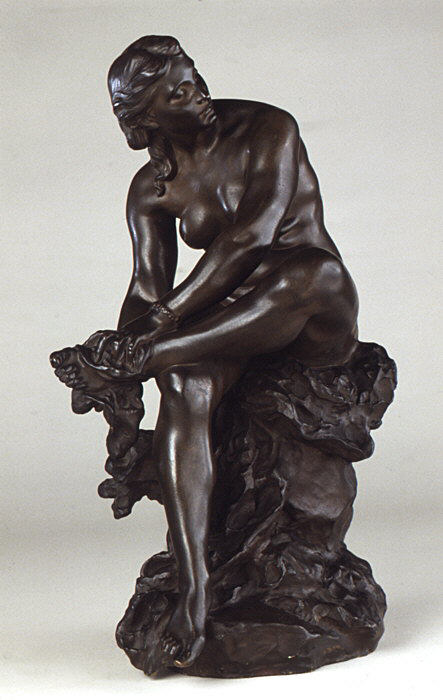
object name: statuette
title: Woman Bathing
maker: aimé-jules dalou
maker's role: artist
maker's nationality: french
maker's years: 1838-1902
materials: bronze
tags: female nudes,bathing